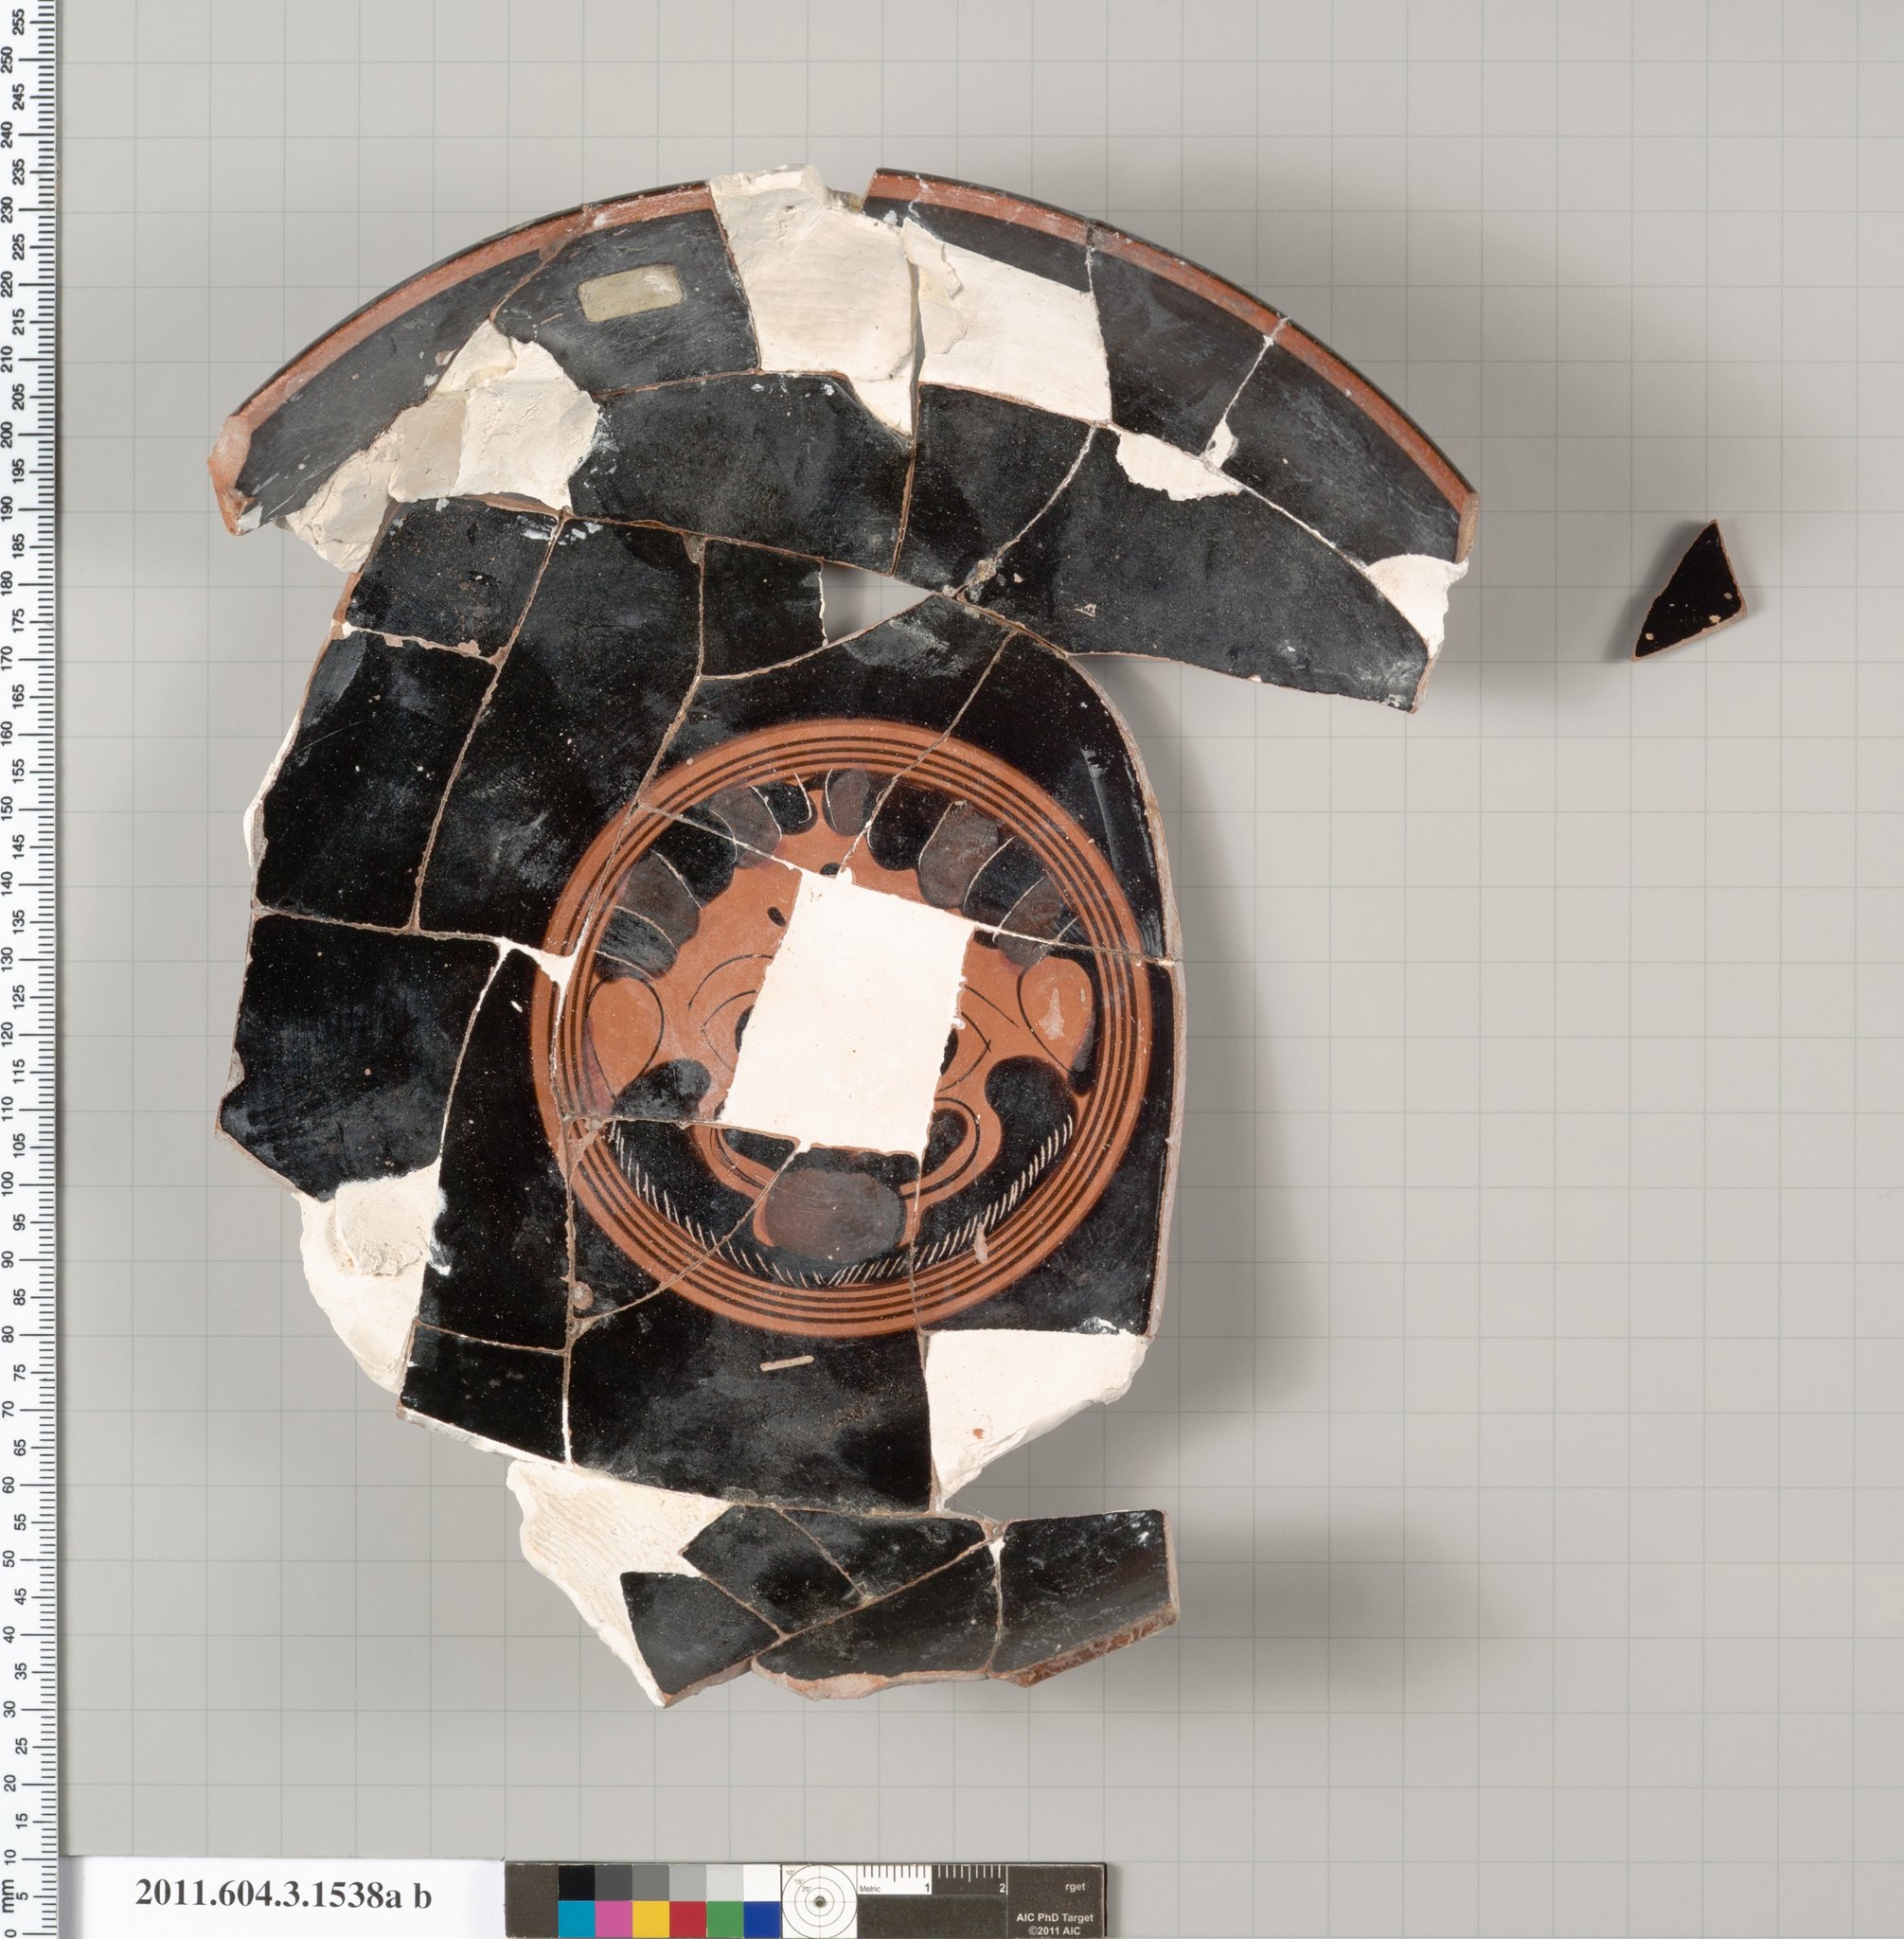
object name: kylix fragment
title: Terracotta fragments of a kylix: eye-cup (drinking cup)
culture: greek, attic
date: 525-501 BCE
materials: terracotta